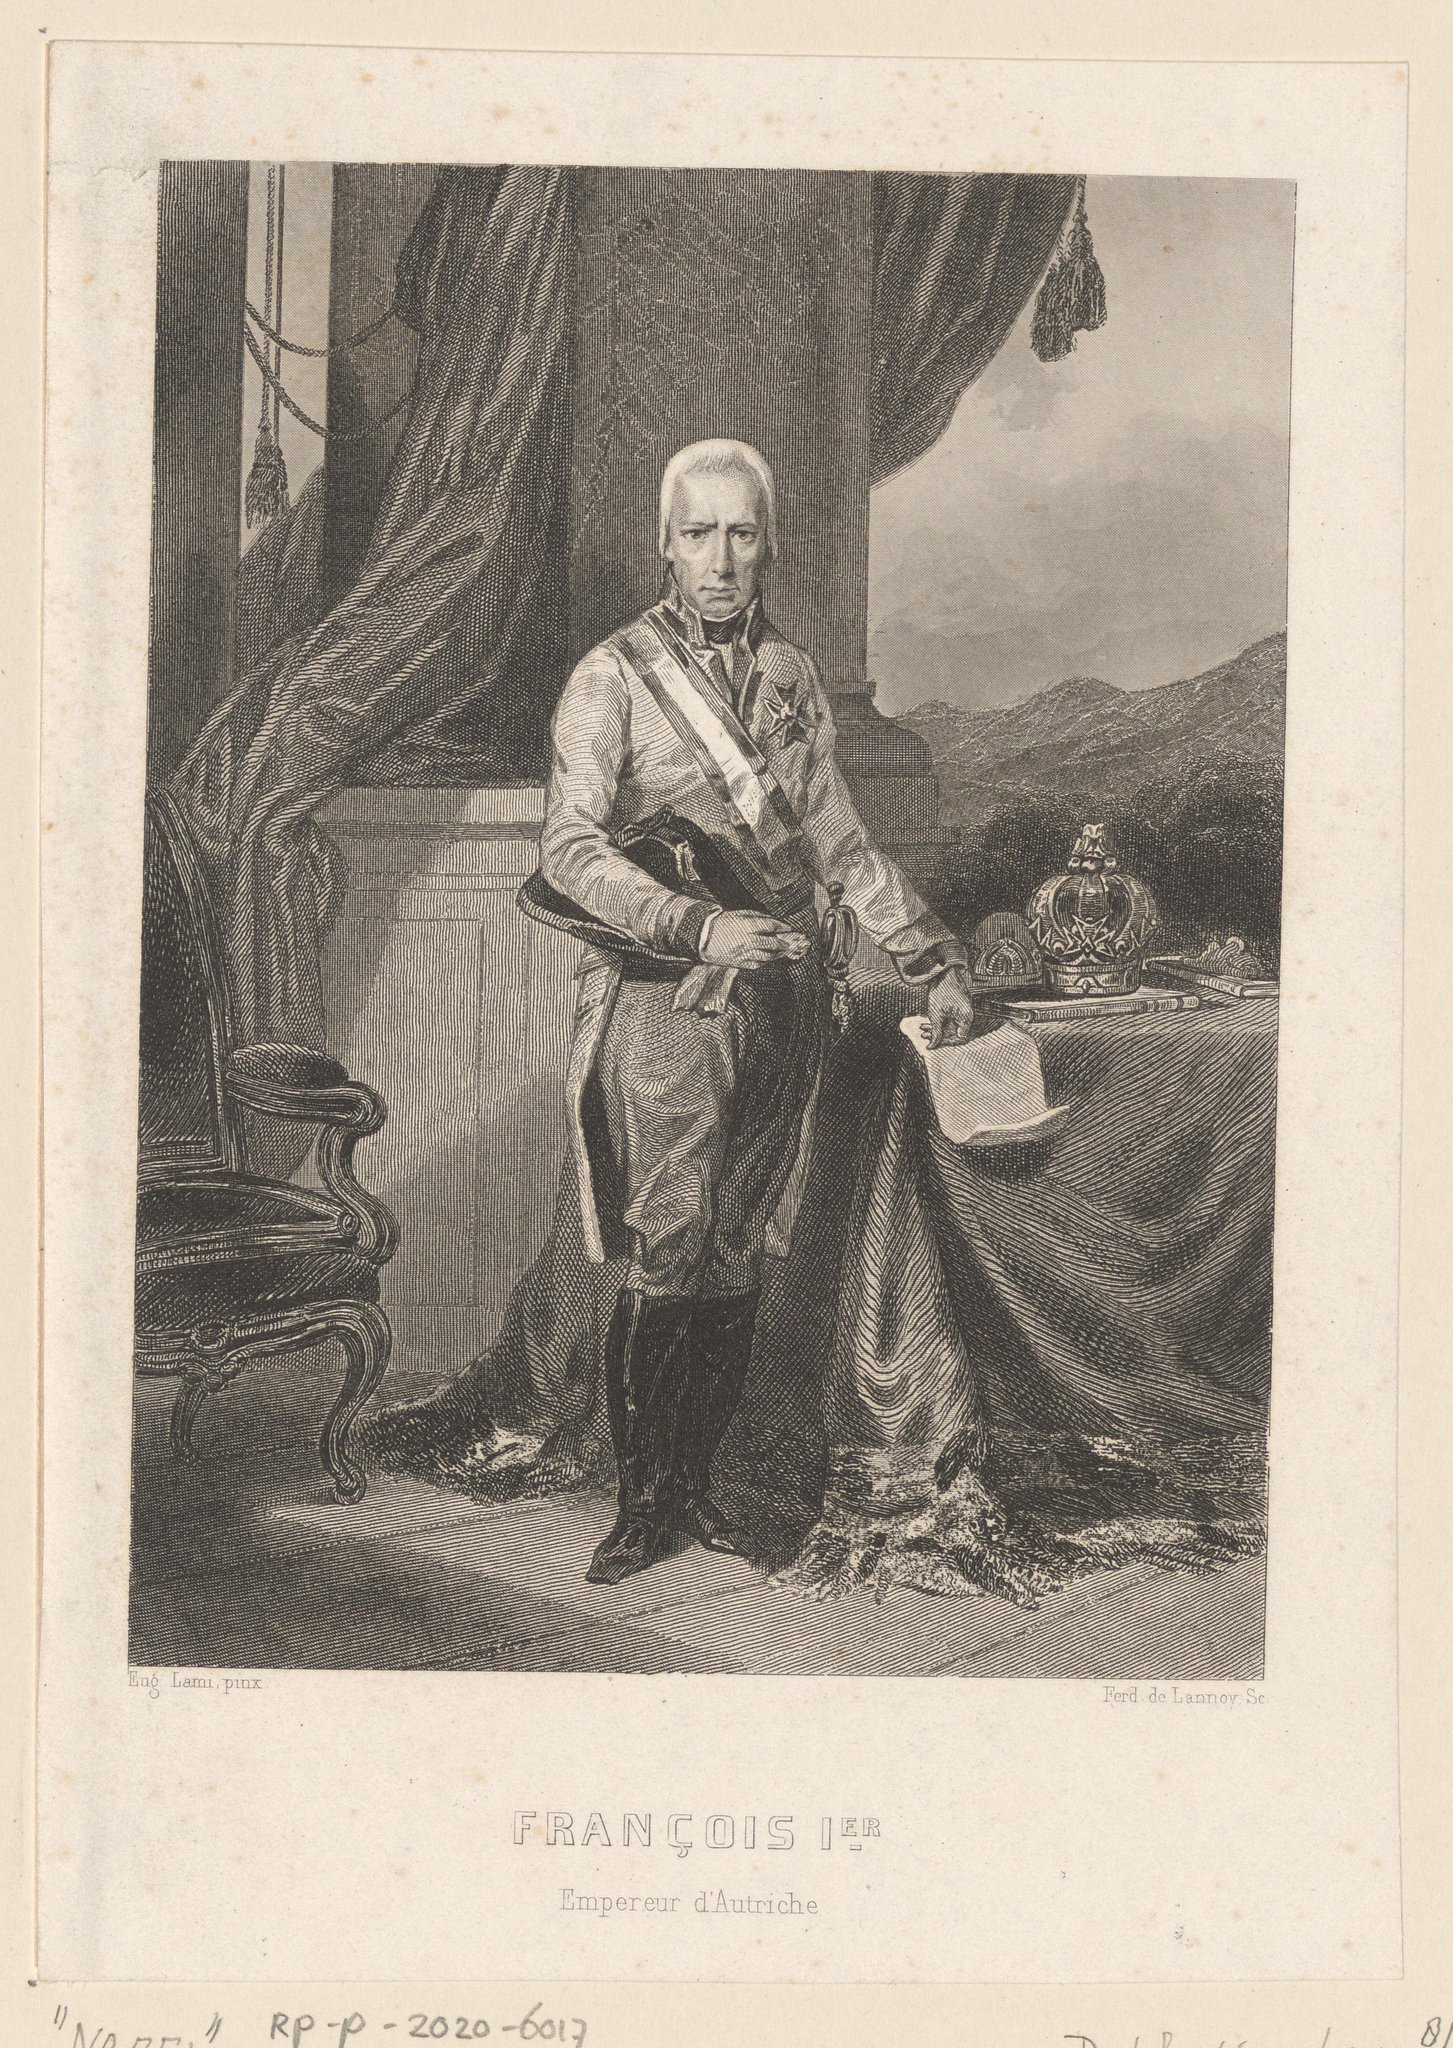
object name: print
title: Portret van Frans I, keizer van Oostenrijk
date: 1832-1887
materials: paper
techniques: etching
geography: france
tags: vienna, frans ii (rooms-duits keizer), crown (symbol of sovereignty), column, pillar ~ architecture, historical persons, emperor, mountains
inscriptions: number: ‘No. 551.’